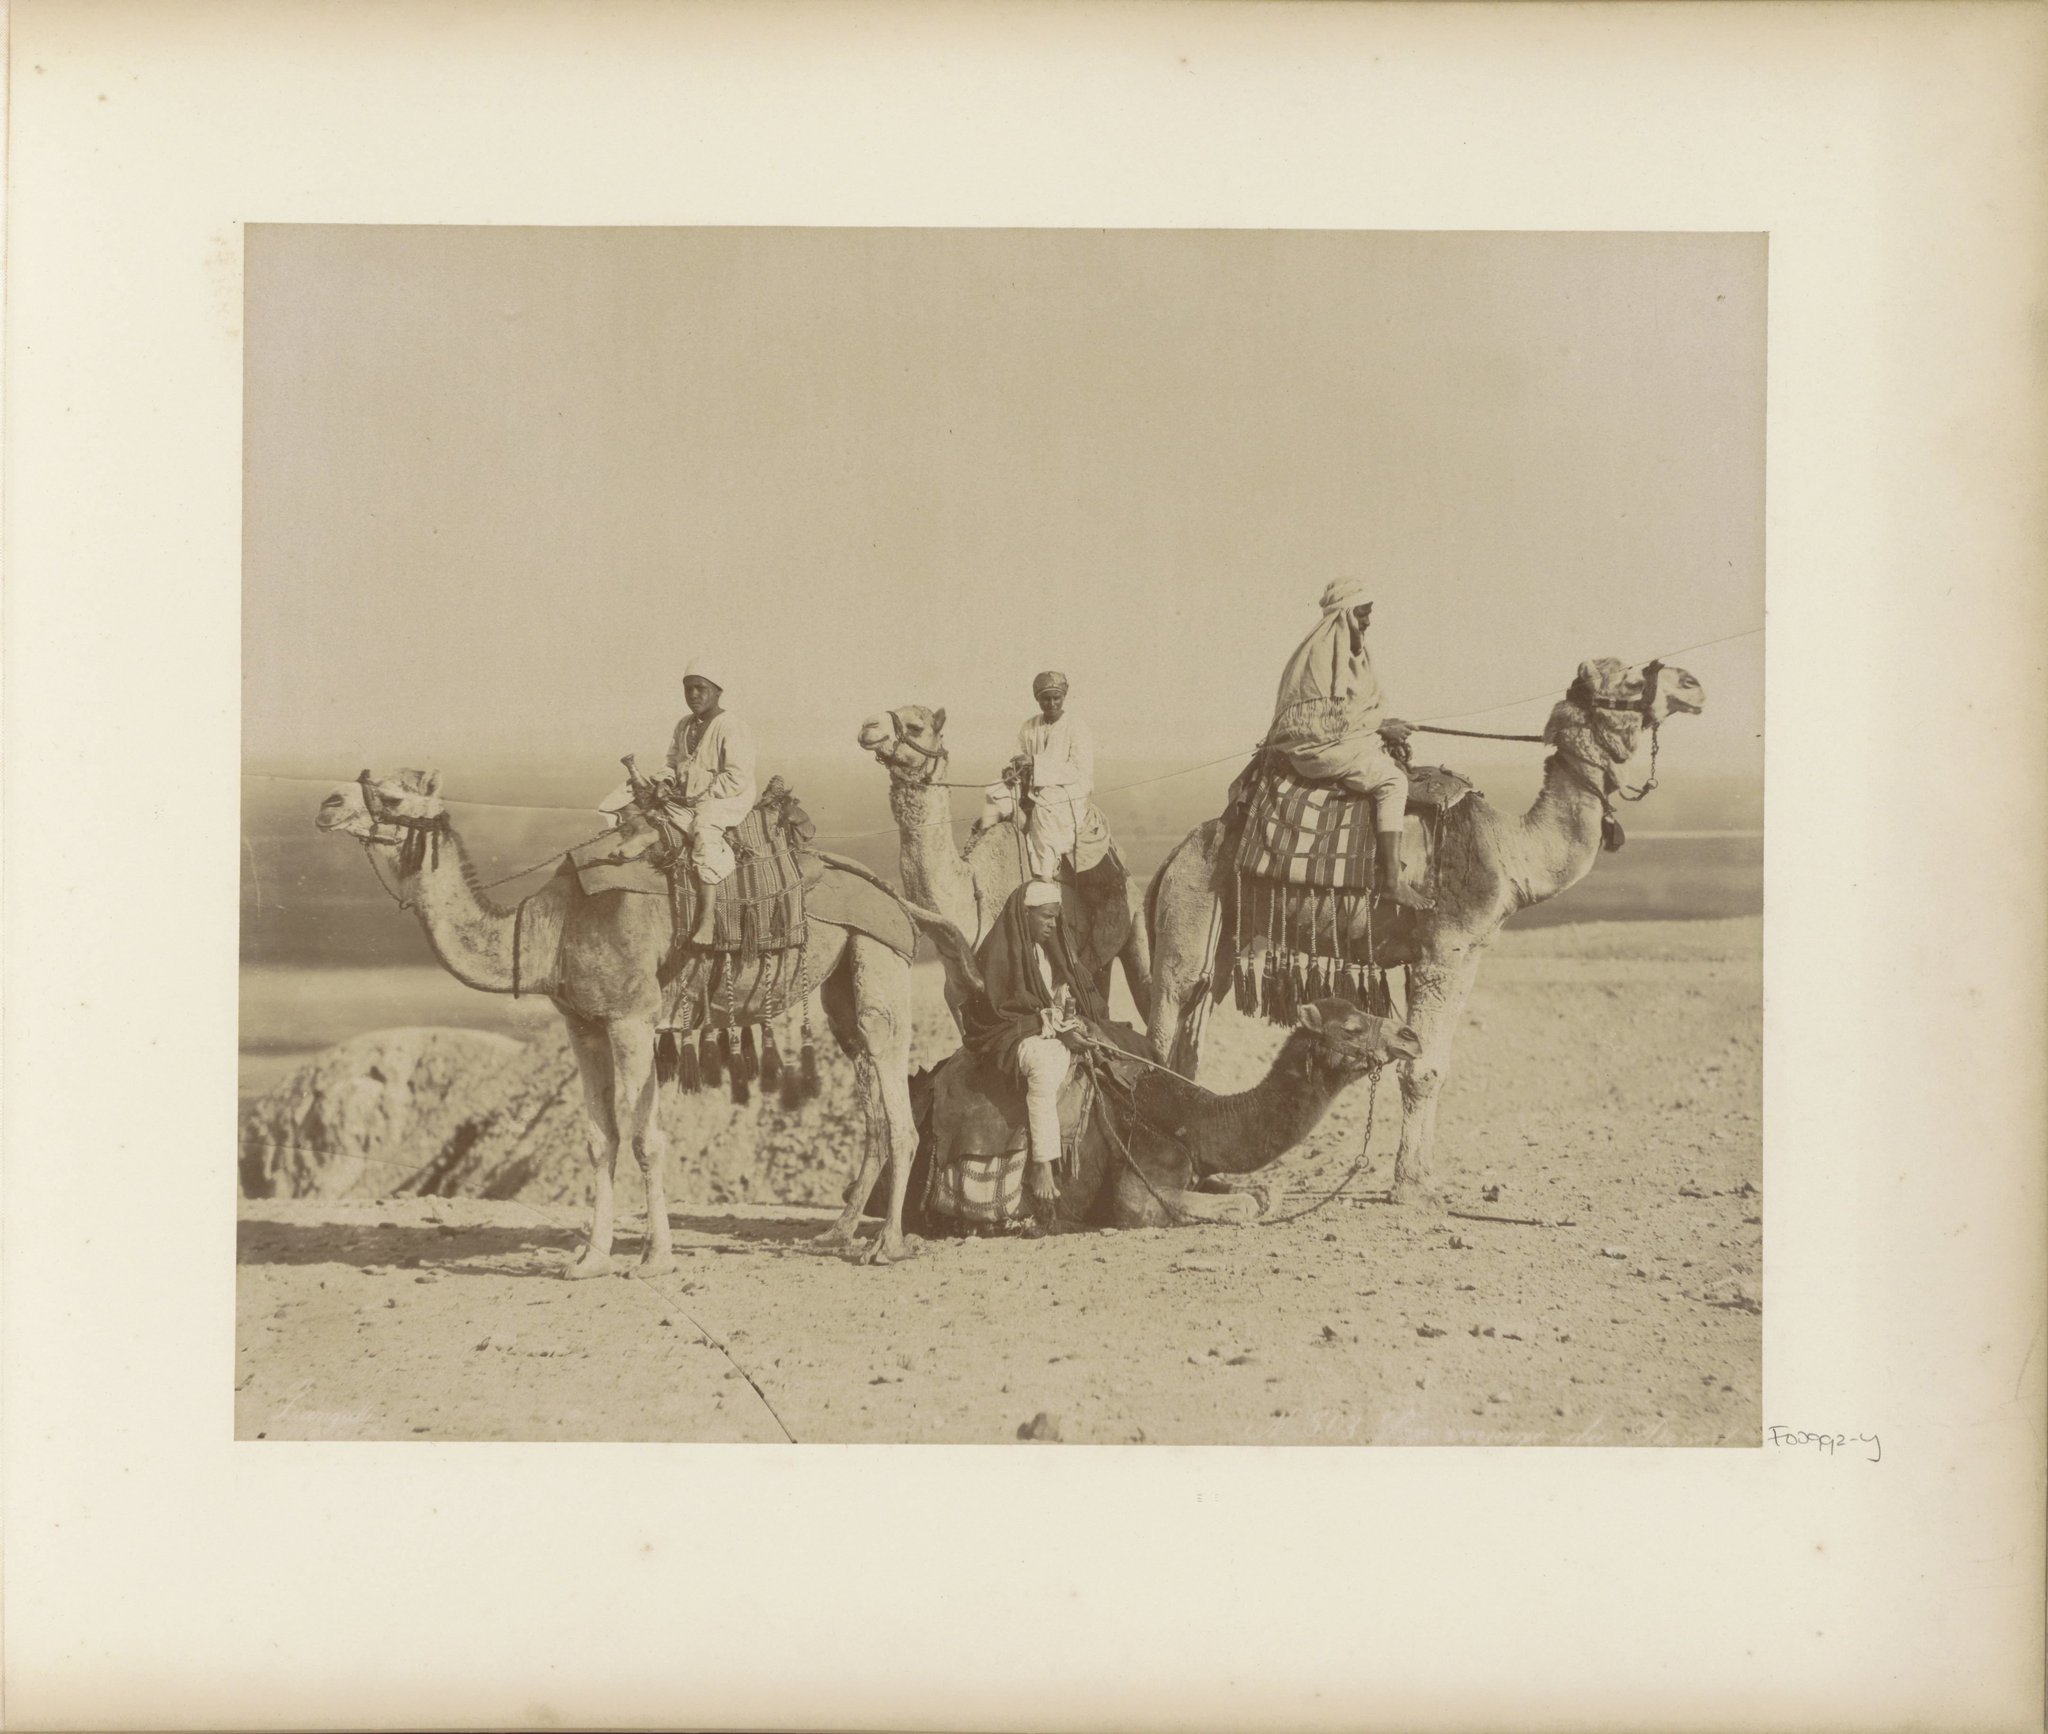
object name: photograph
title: Ruiters op kamelen in een Egyptische woestijn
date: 1870-1890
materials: cardboard, paper, photographic support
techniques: albumen print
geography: egypt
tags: riding on animal other than horse, ass, or mule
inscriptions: negative number: ‘503’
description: Onderdeel van Reisalbum met 80 foto's van Egypte.